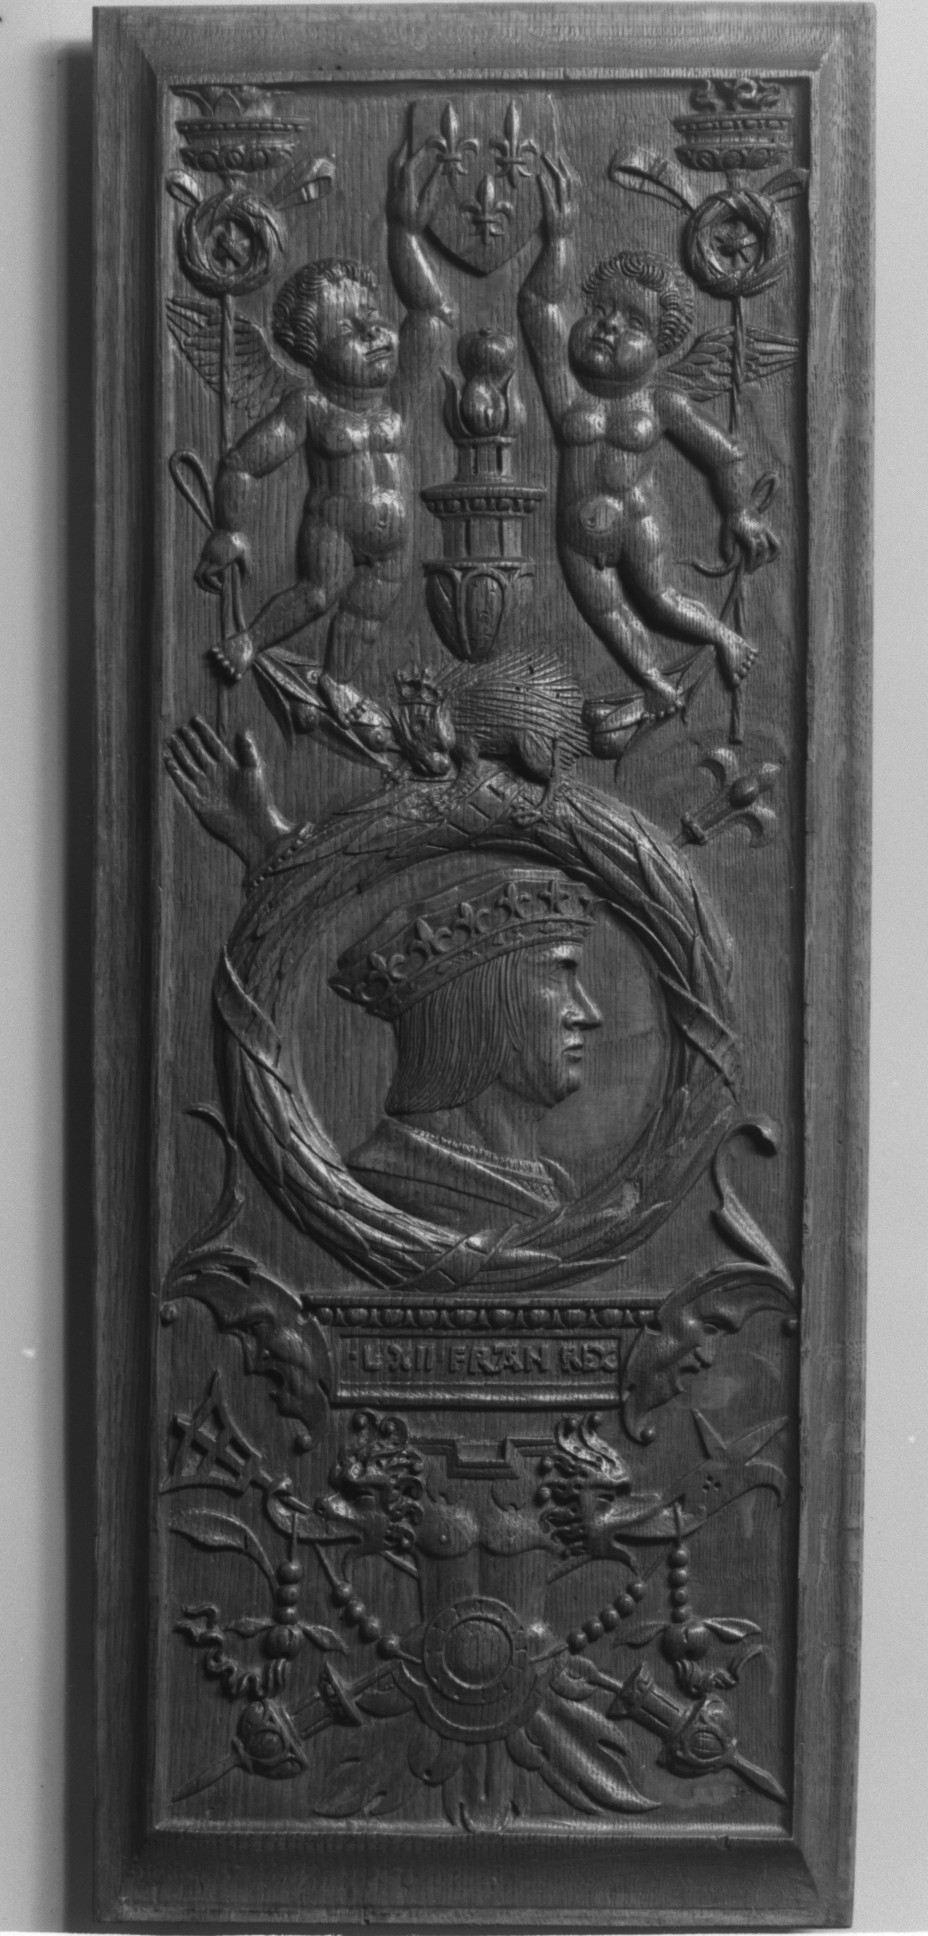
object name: panel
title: Panel (part of a set)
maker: nicolas castille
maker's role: maker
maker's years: 1503-1521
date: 1510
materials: wood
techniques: carving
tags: men,profiles,putti